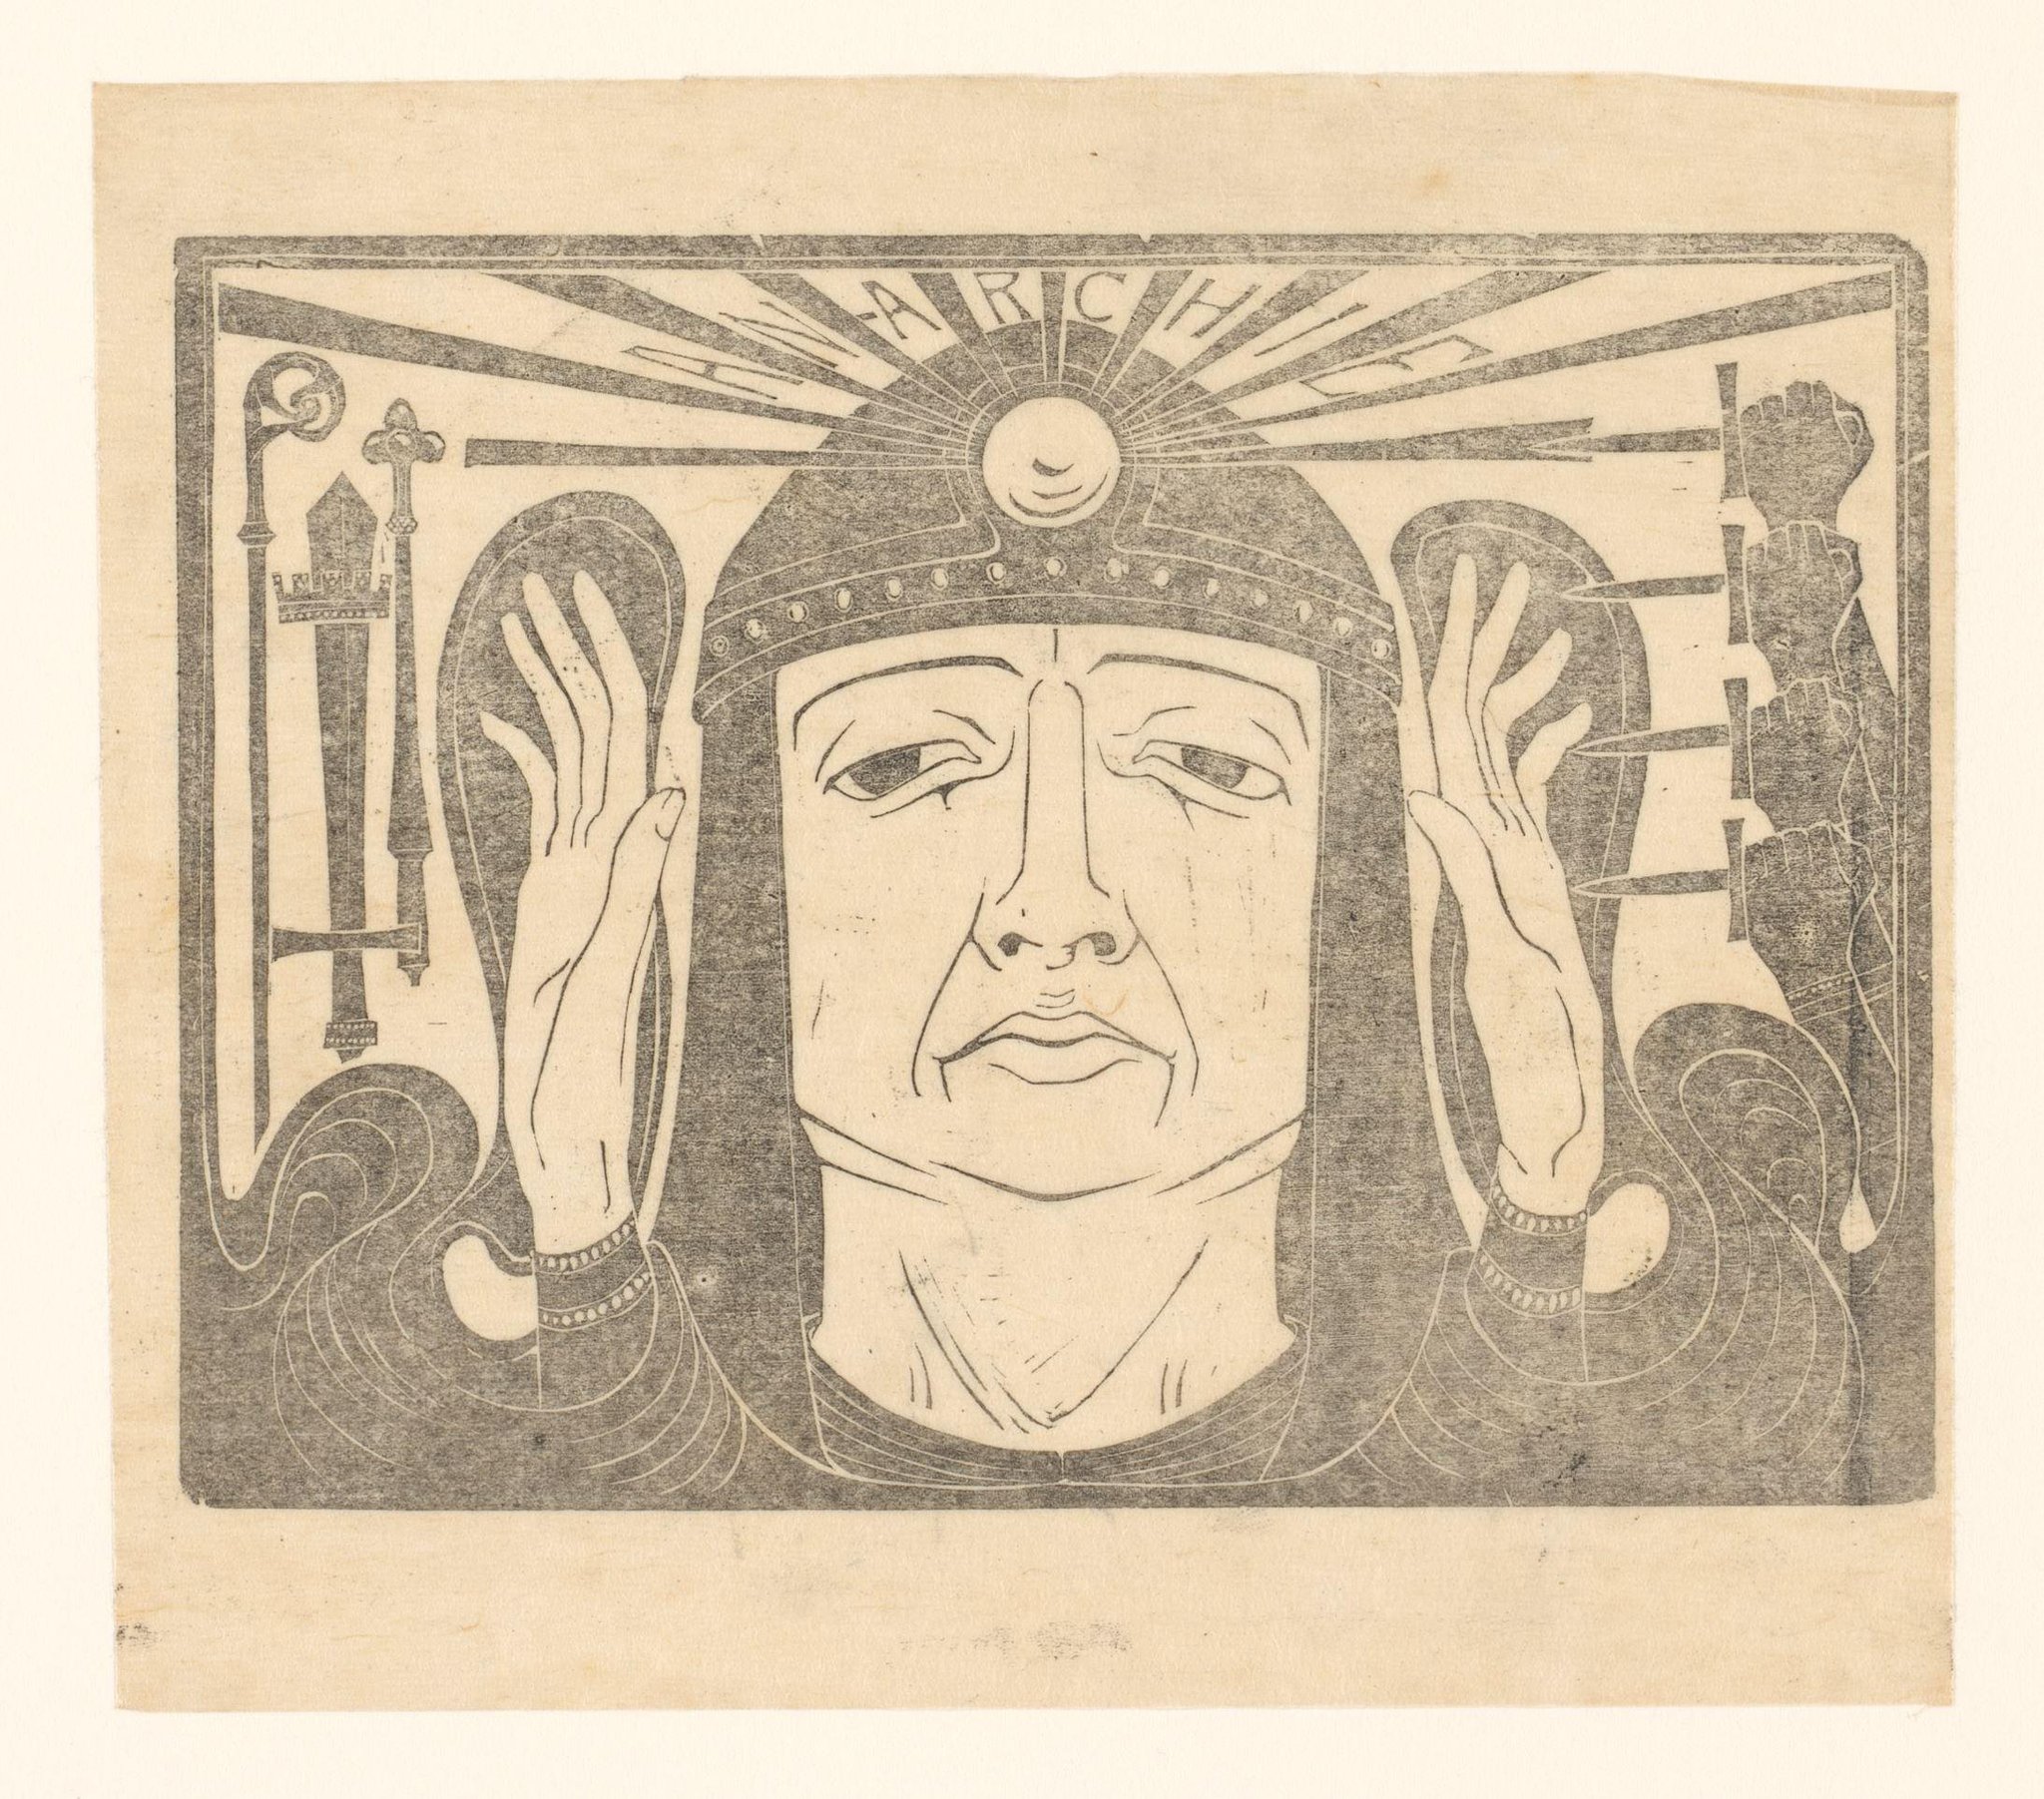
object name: print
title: Argonauten: Psychische kracht onaantastbaar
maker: karel petrus cornelis de bazel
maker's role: draughtsman, print maker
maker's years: 1869-1923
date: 1894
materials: paper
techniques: woodcut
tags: helmet, face, sceptre, staff (symbol of sovereignty), hacking and thrusting weapons: dagger, hacking and thrusting weapons: sword, radiance emanating from persons or things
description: Een gezicht dat 'Psychische kracht' verbeeldt vaart op een woelige zee tussen het 'hogere' (scepter, staf en gekroond zwaard) en het 'lagere' (handen met dolken). Uit het gehelmde voorhoofd van 'Psychische kracht' komen stralen met daartussen het woord 'Anarchie'.